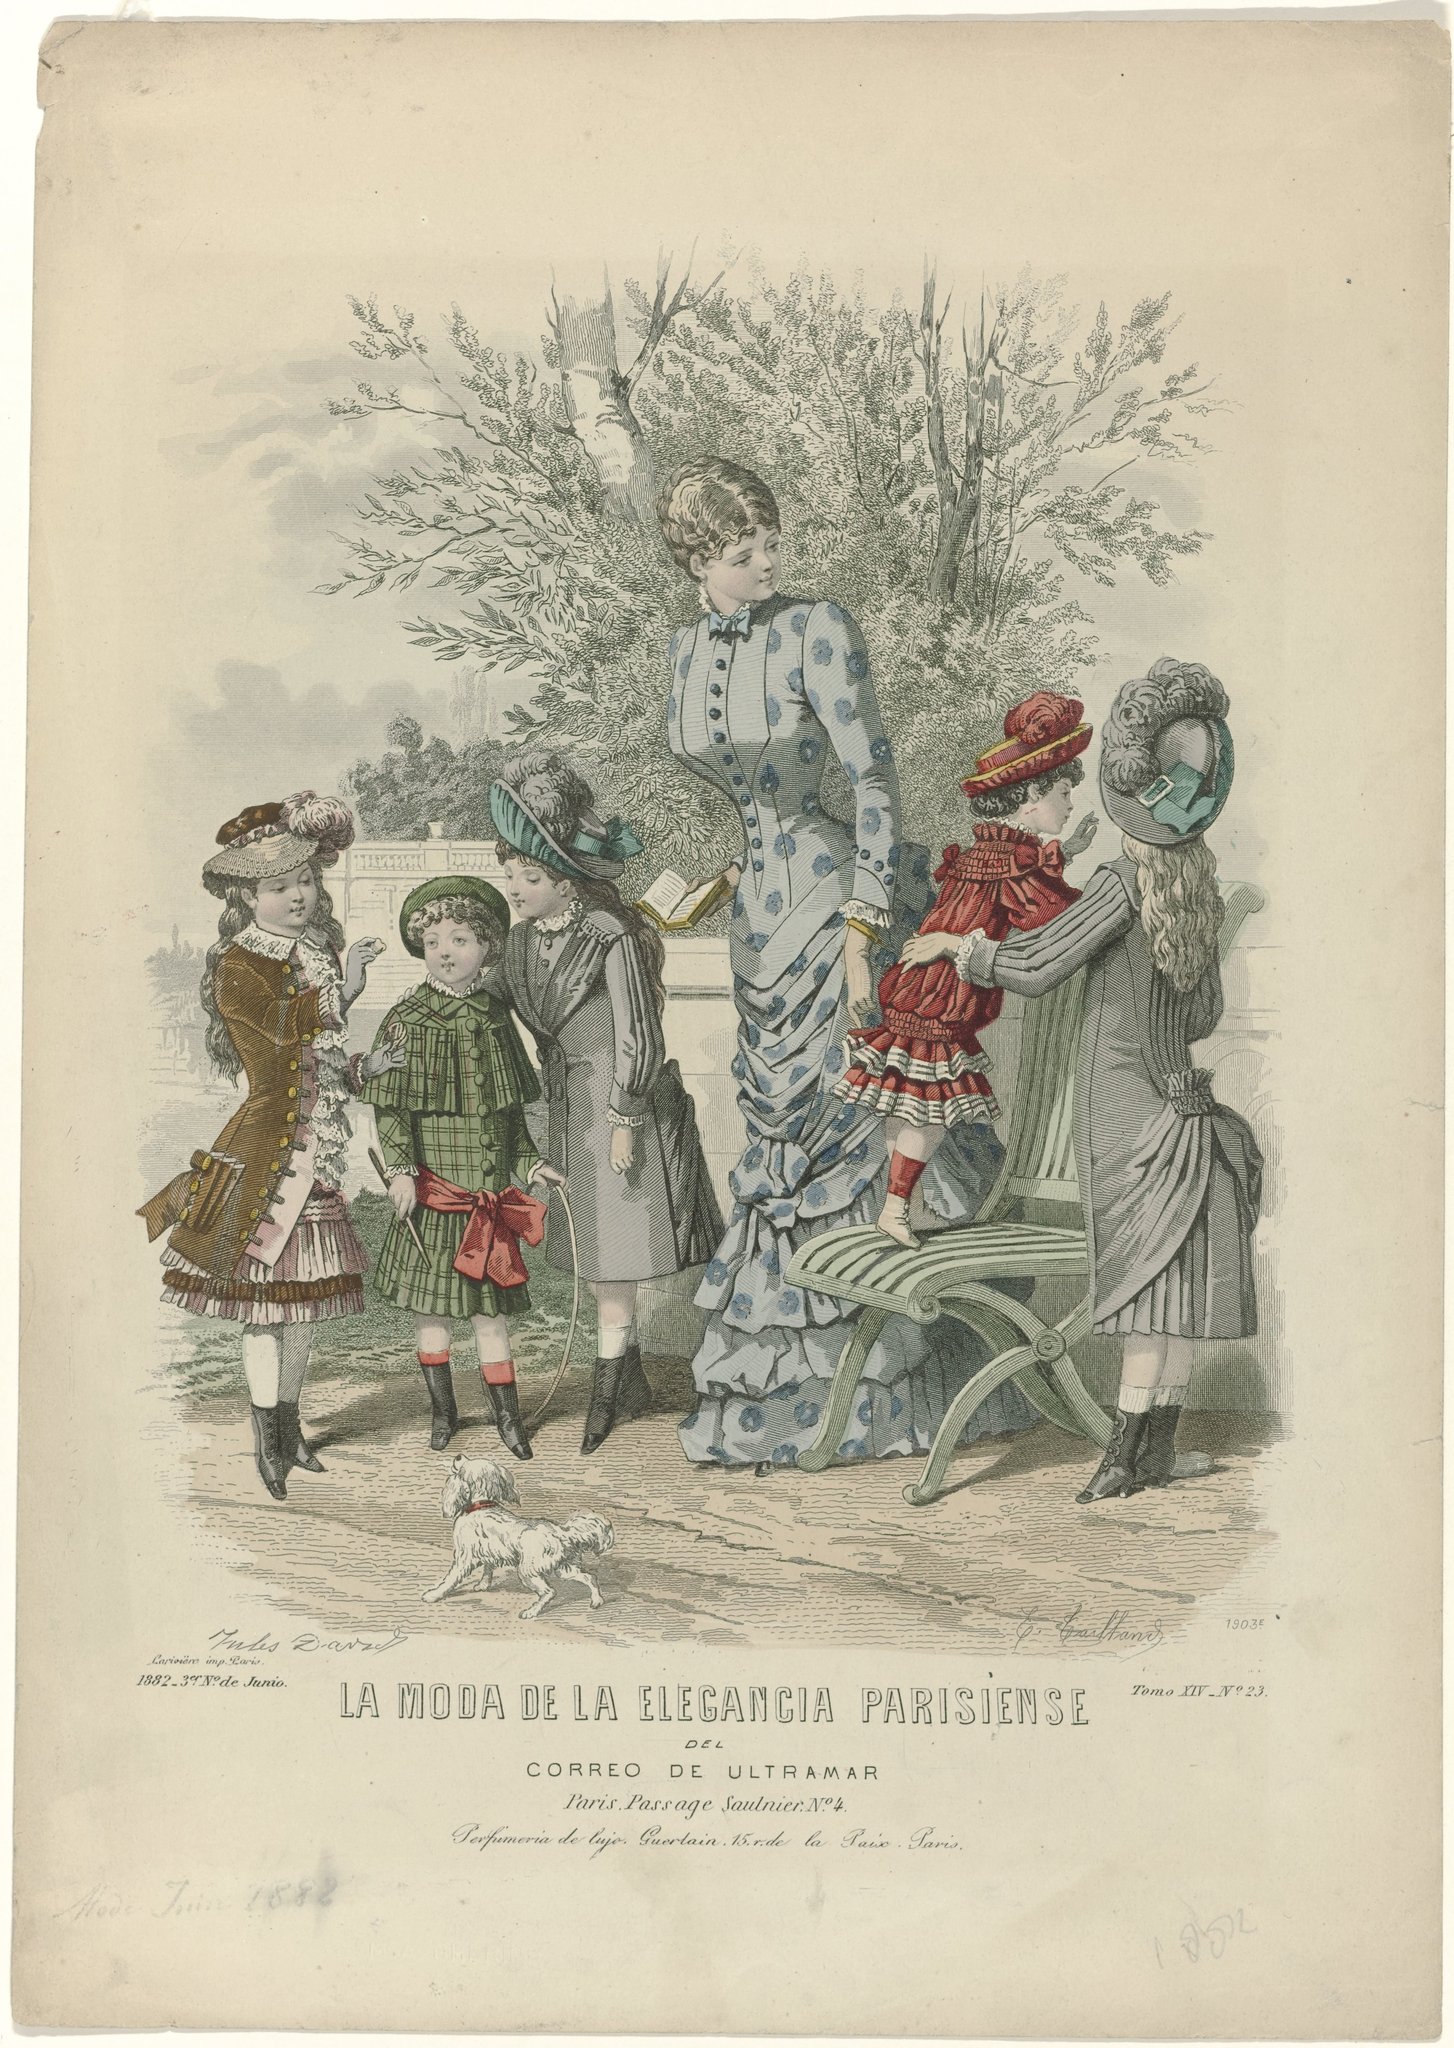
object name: fashion print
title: La Moda de la Elegancia Parisiense del Correo de Ultramar, Junio 1882, Tomo XIV, No. 23, nr. 1903E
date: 1882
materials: paper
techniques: engraving, hand coloring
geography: paris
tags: fashion plates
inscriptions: date